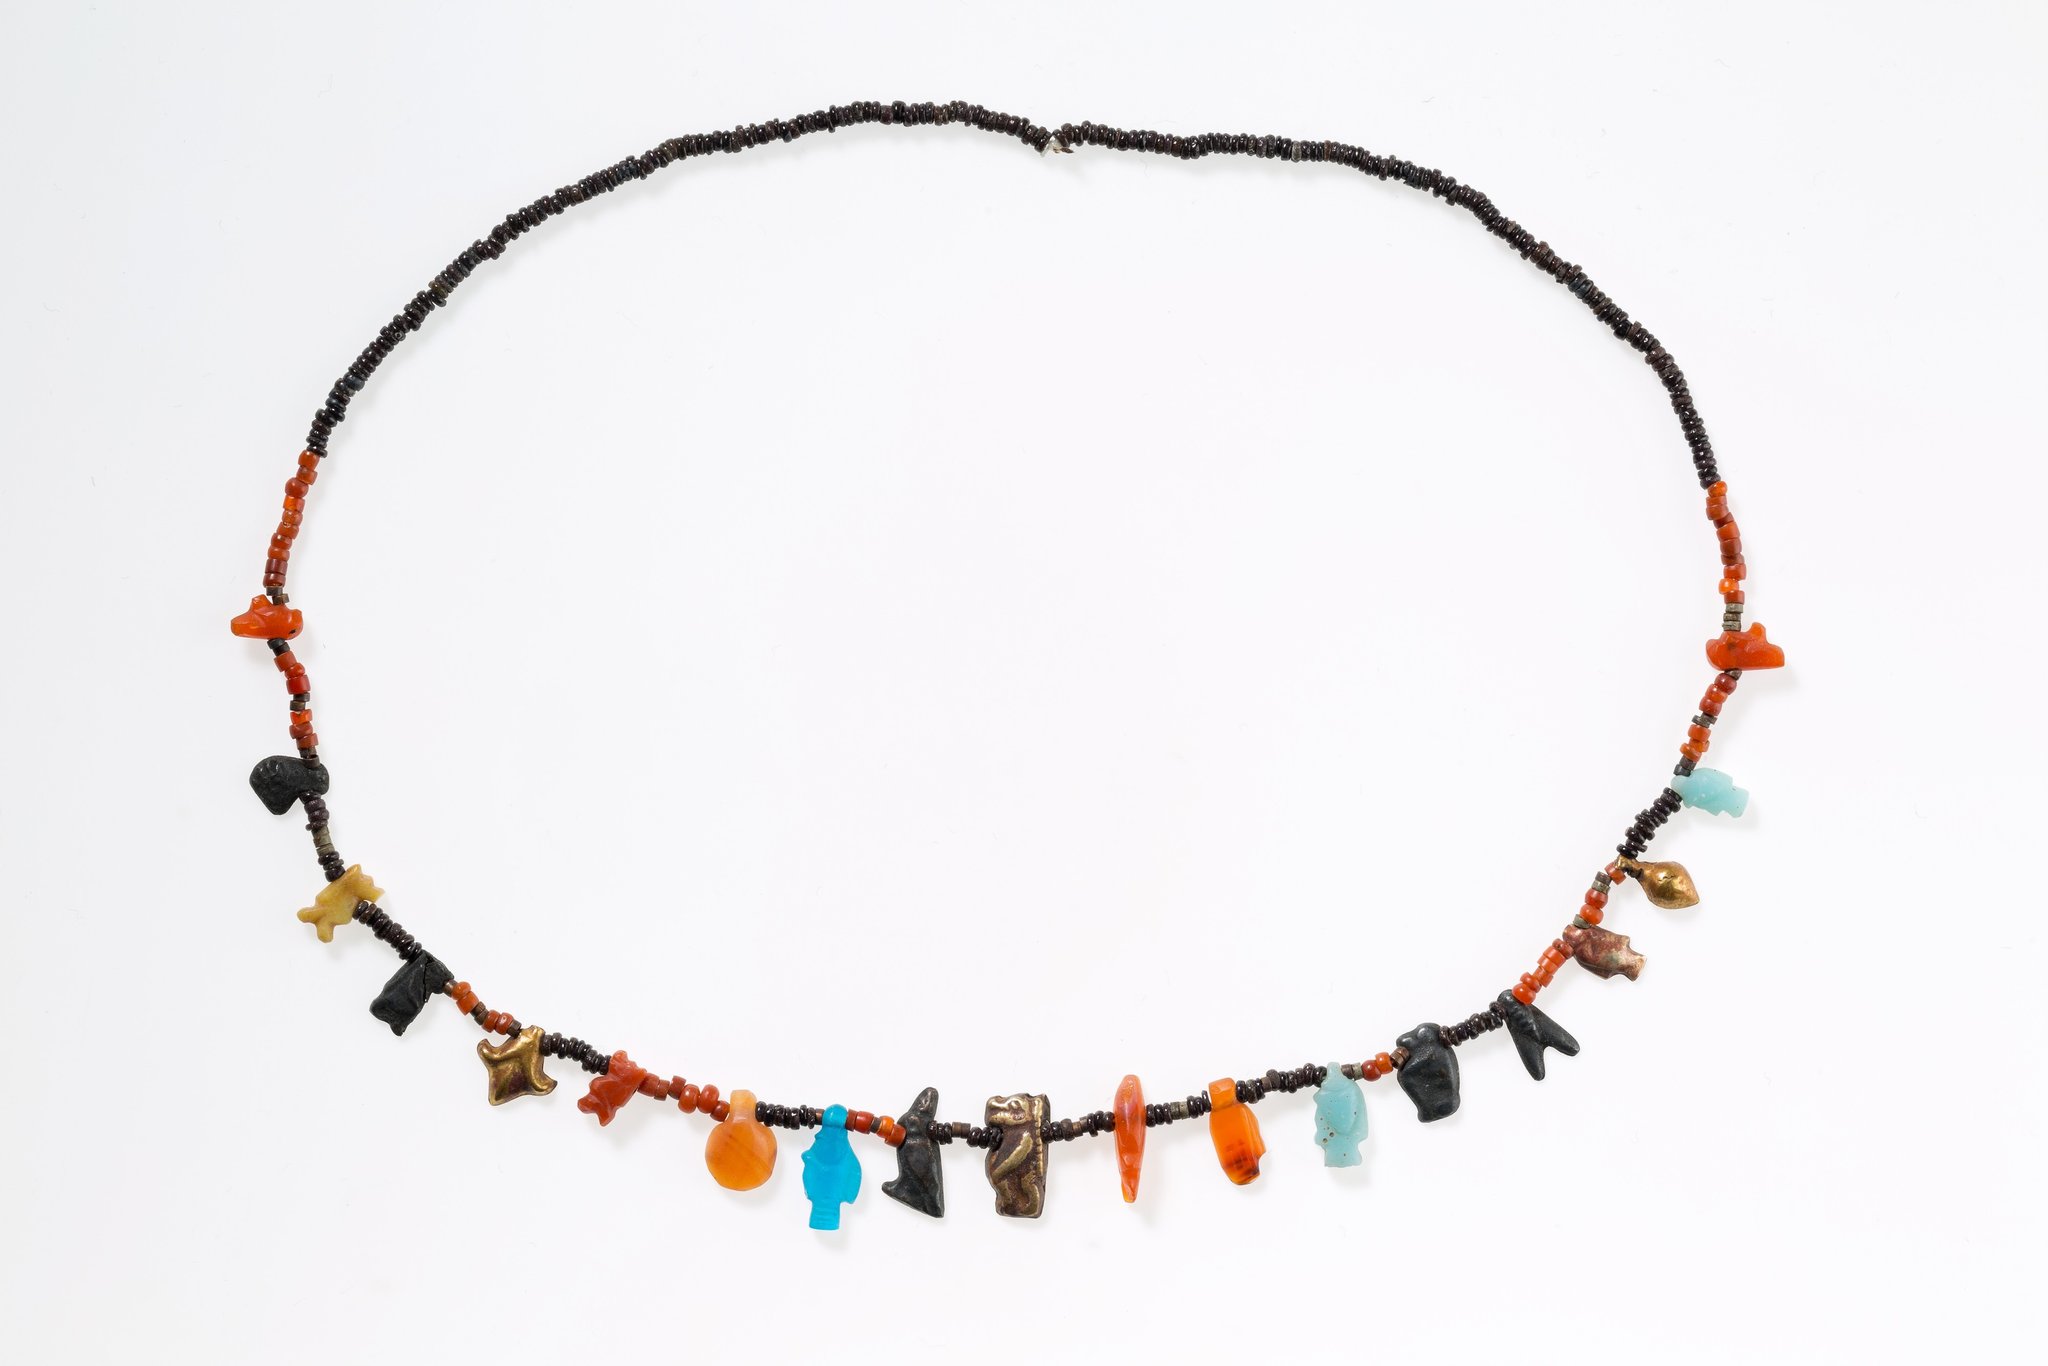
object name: necklace, bead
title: Necklace with disc beads and amulets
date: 1550-1425 BCE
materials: gemstone, faience, glass, gold, silver, stone, tin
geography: egypt